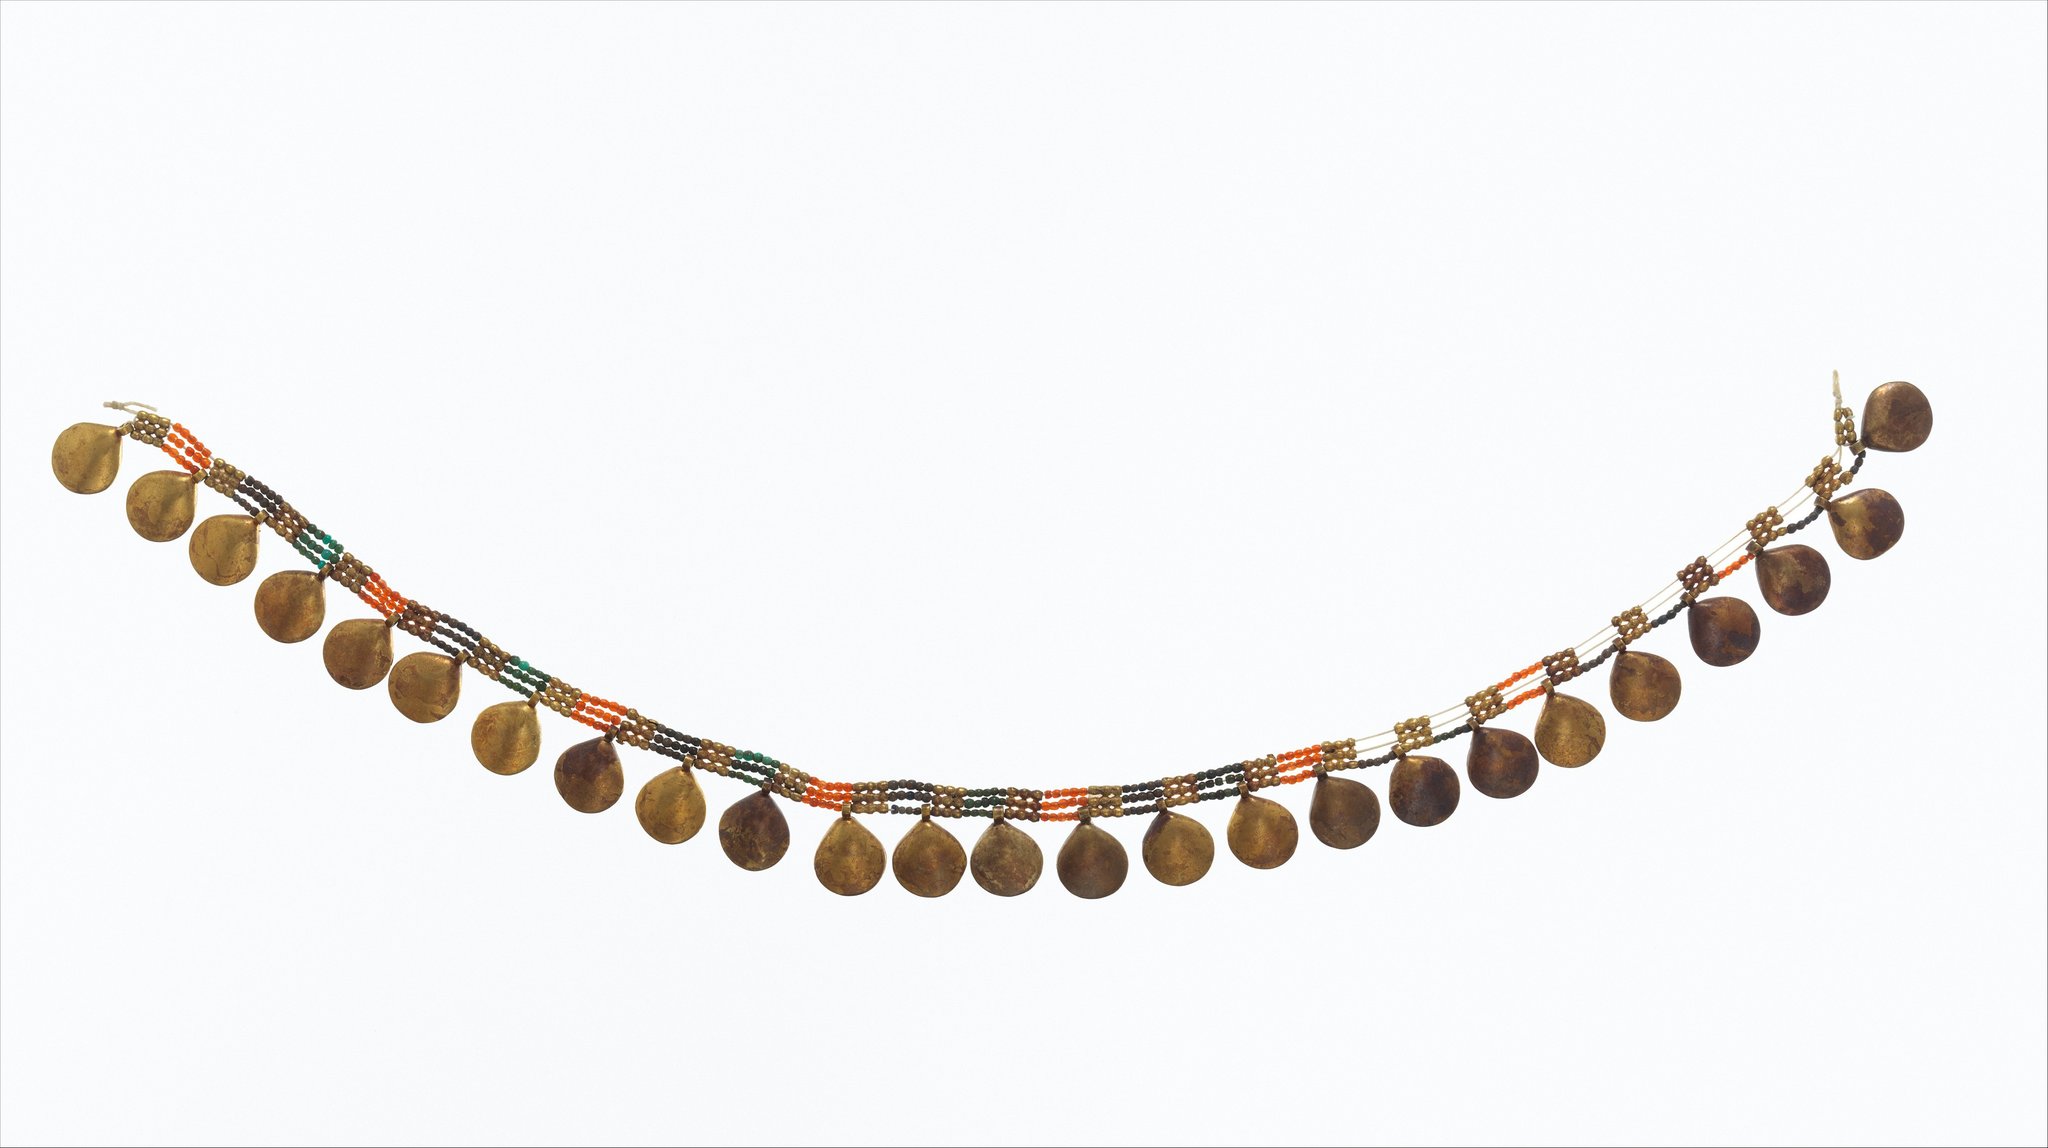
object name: necklace, shell pendant, senebtisi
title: Necklace with shell pendants of Senebtisi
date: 1859-1770 BCE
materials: gemstone, faience, gold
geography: egypt